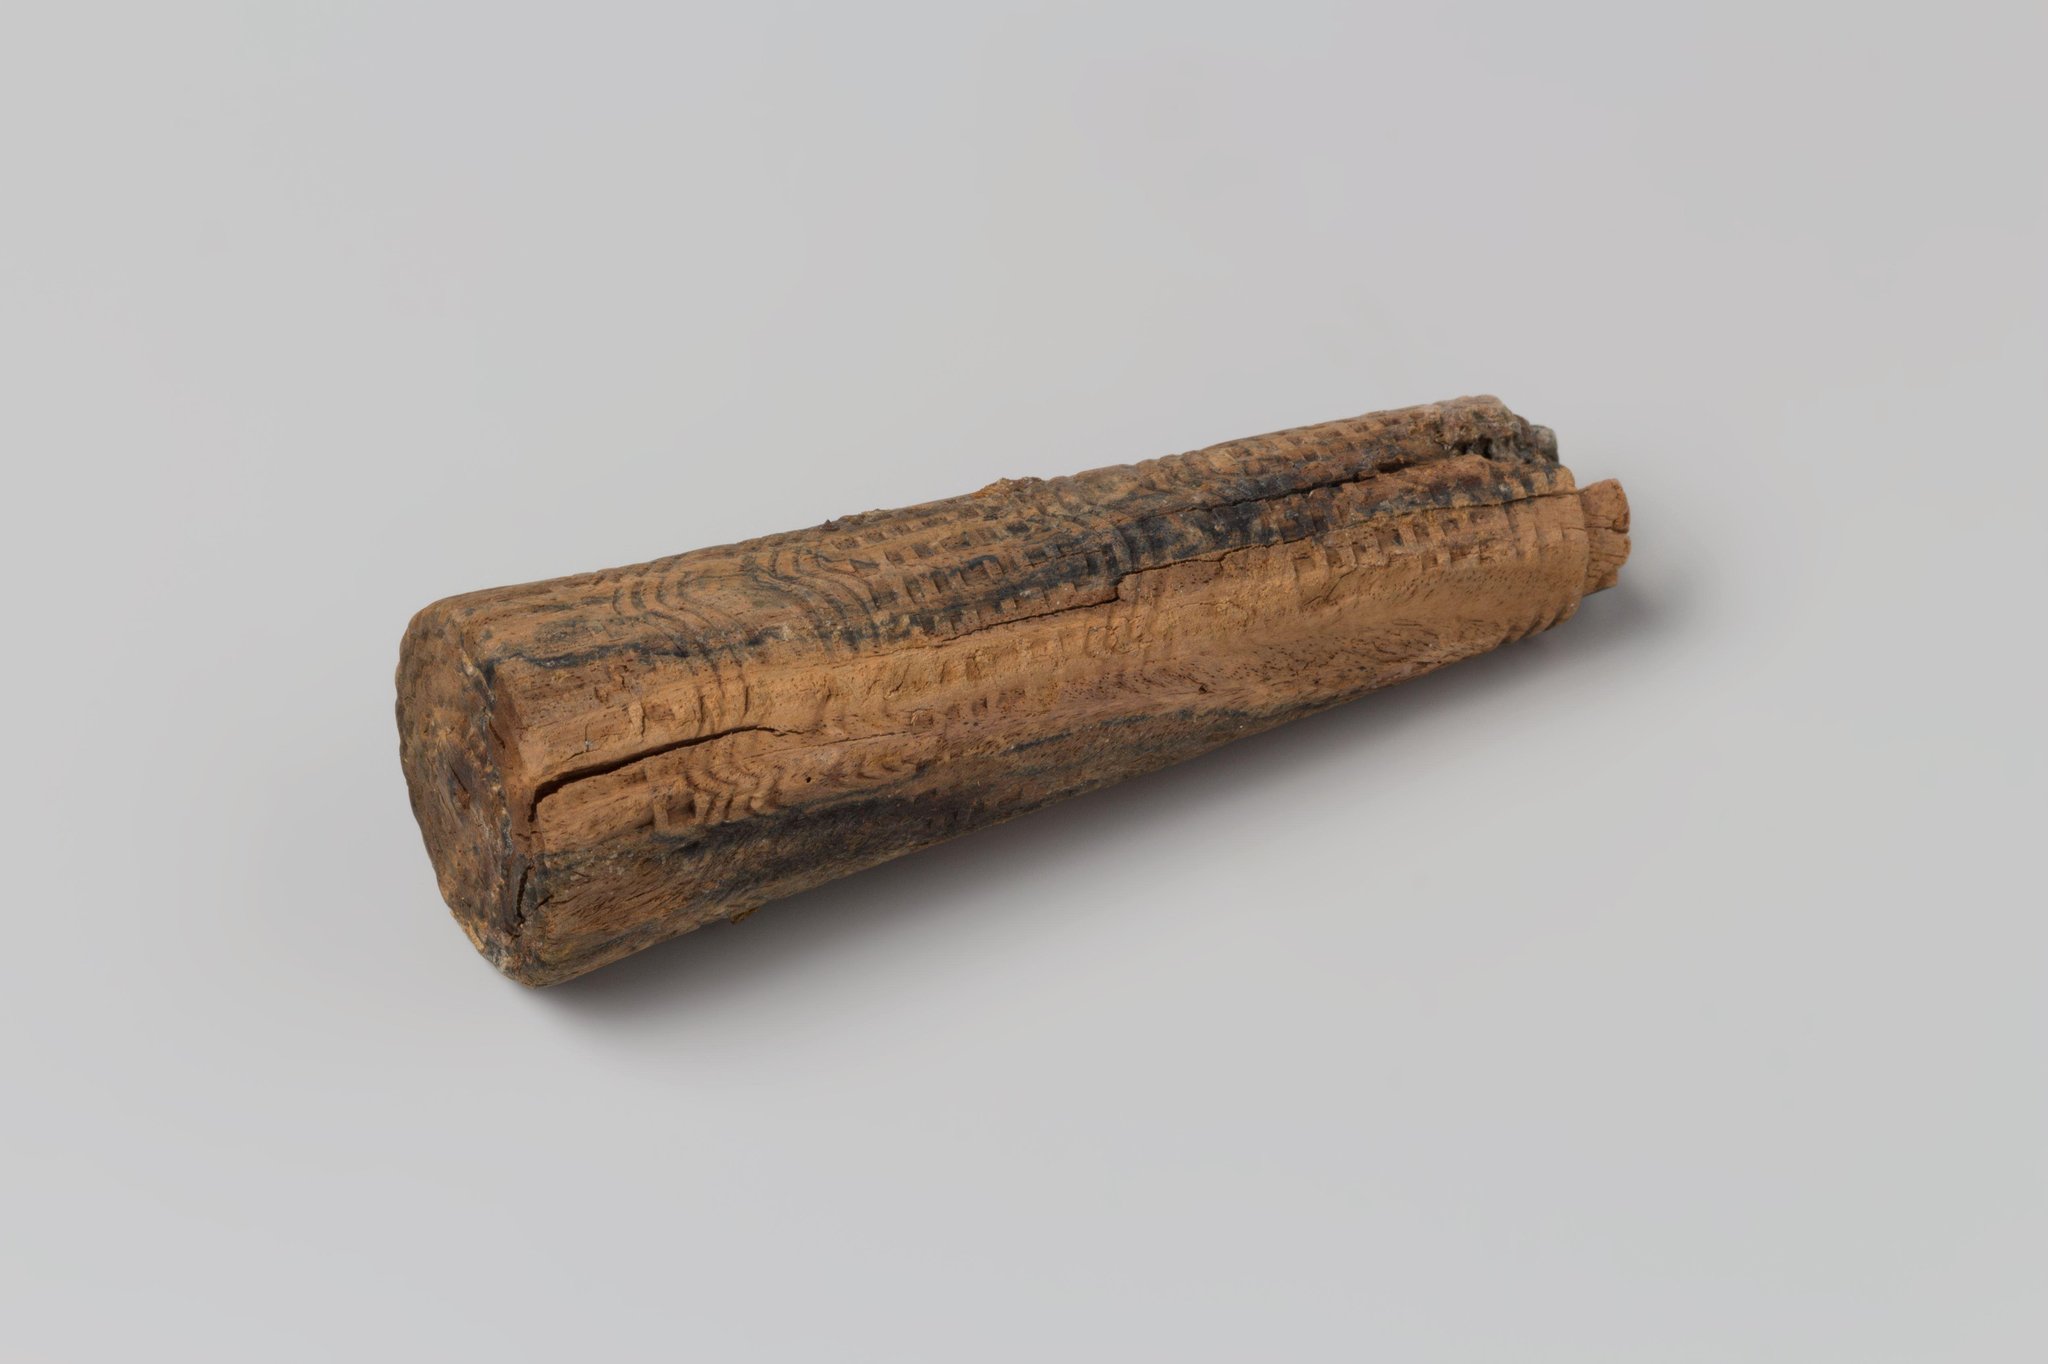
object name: knife handle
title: Messenheft uit het wrak van de Oost-Indiëvaarder Hollandia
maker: Anonymous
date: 1700-1743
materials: wood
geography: netherlands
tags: verenigde oostindische compagnie, hollandia (schip), annet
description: Knife, handle, cylindrical: tapering; id. NG 1979-403H, ferrules, id. NG 1980-27H426.